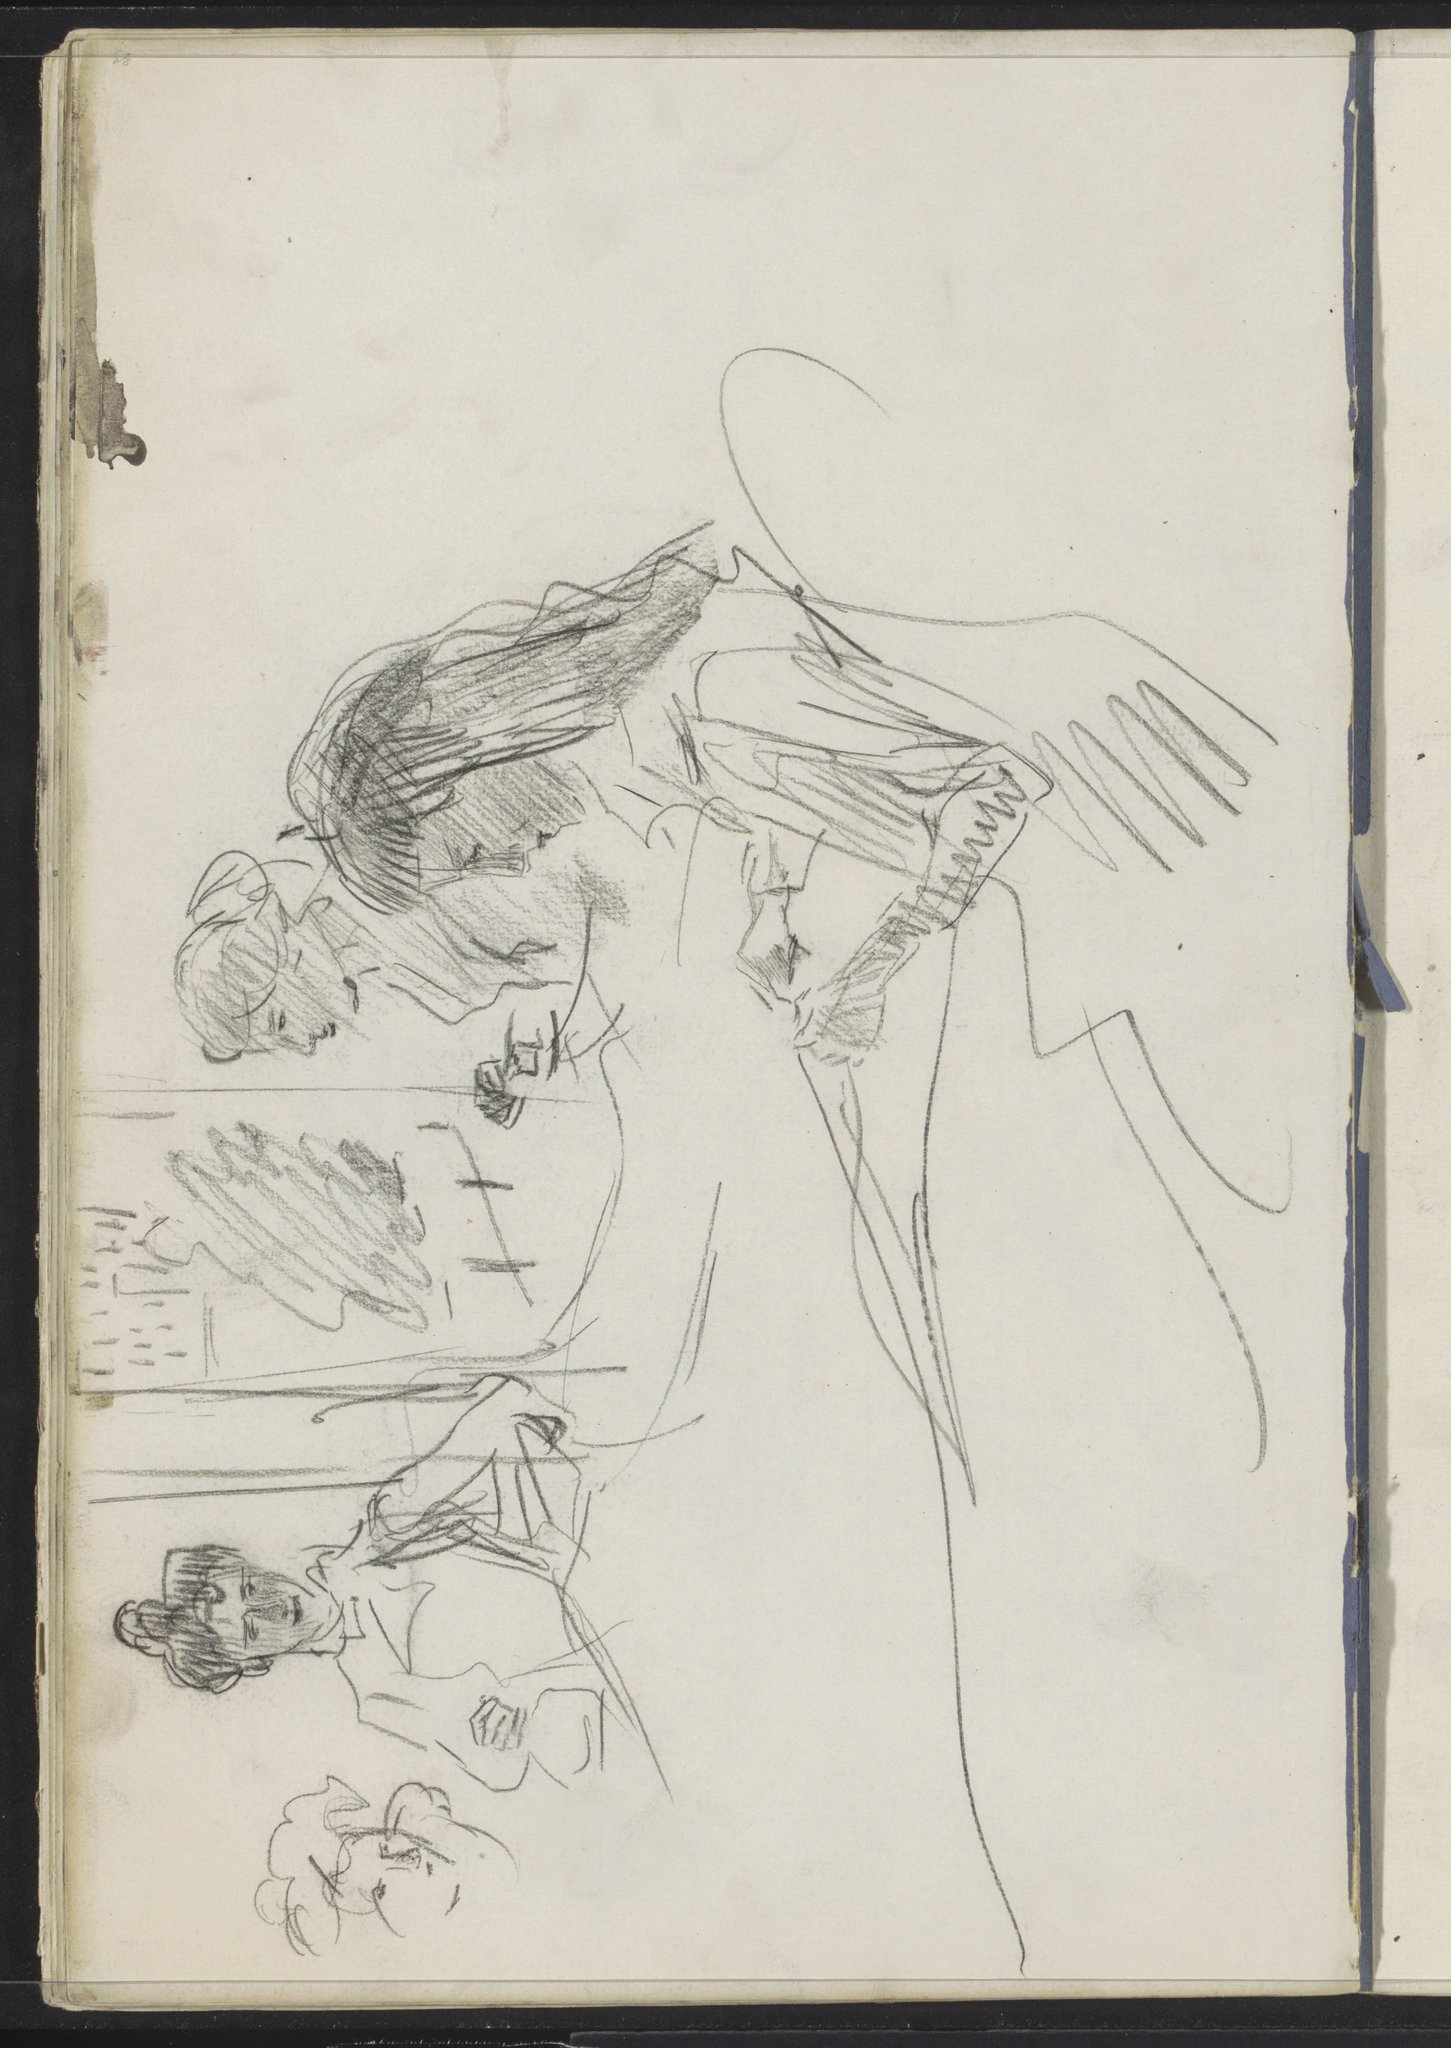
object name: sketchbook leaf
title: Naaisters aan het werk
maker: isaac israels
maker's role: draughtsman, painter, print maker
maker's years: 1865-1934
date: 1875-1934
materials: chalk, paper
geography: the hague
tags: interior of the house, sewing, working class, labourers - aa - women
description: Blad 18 verso uit schetsboek LXIX met 25 bladen.